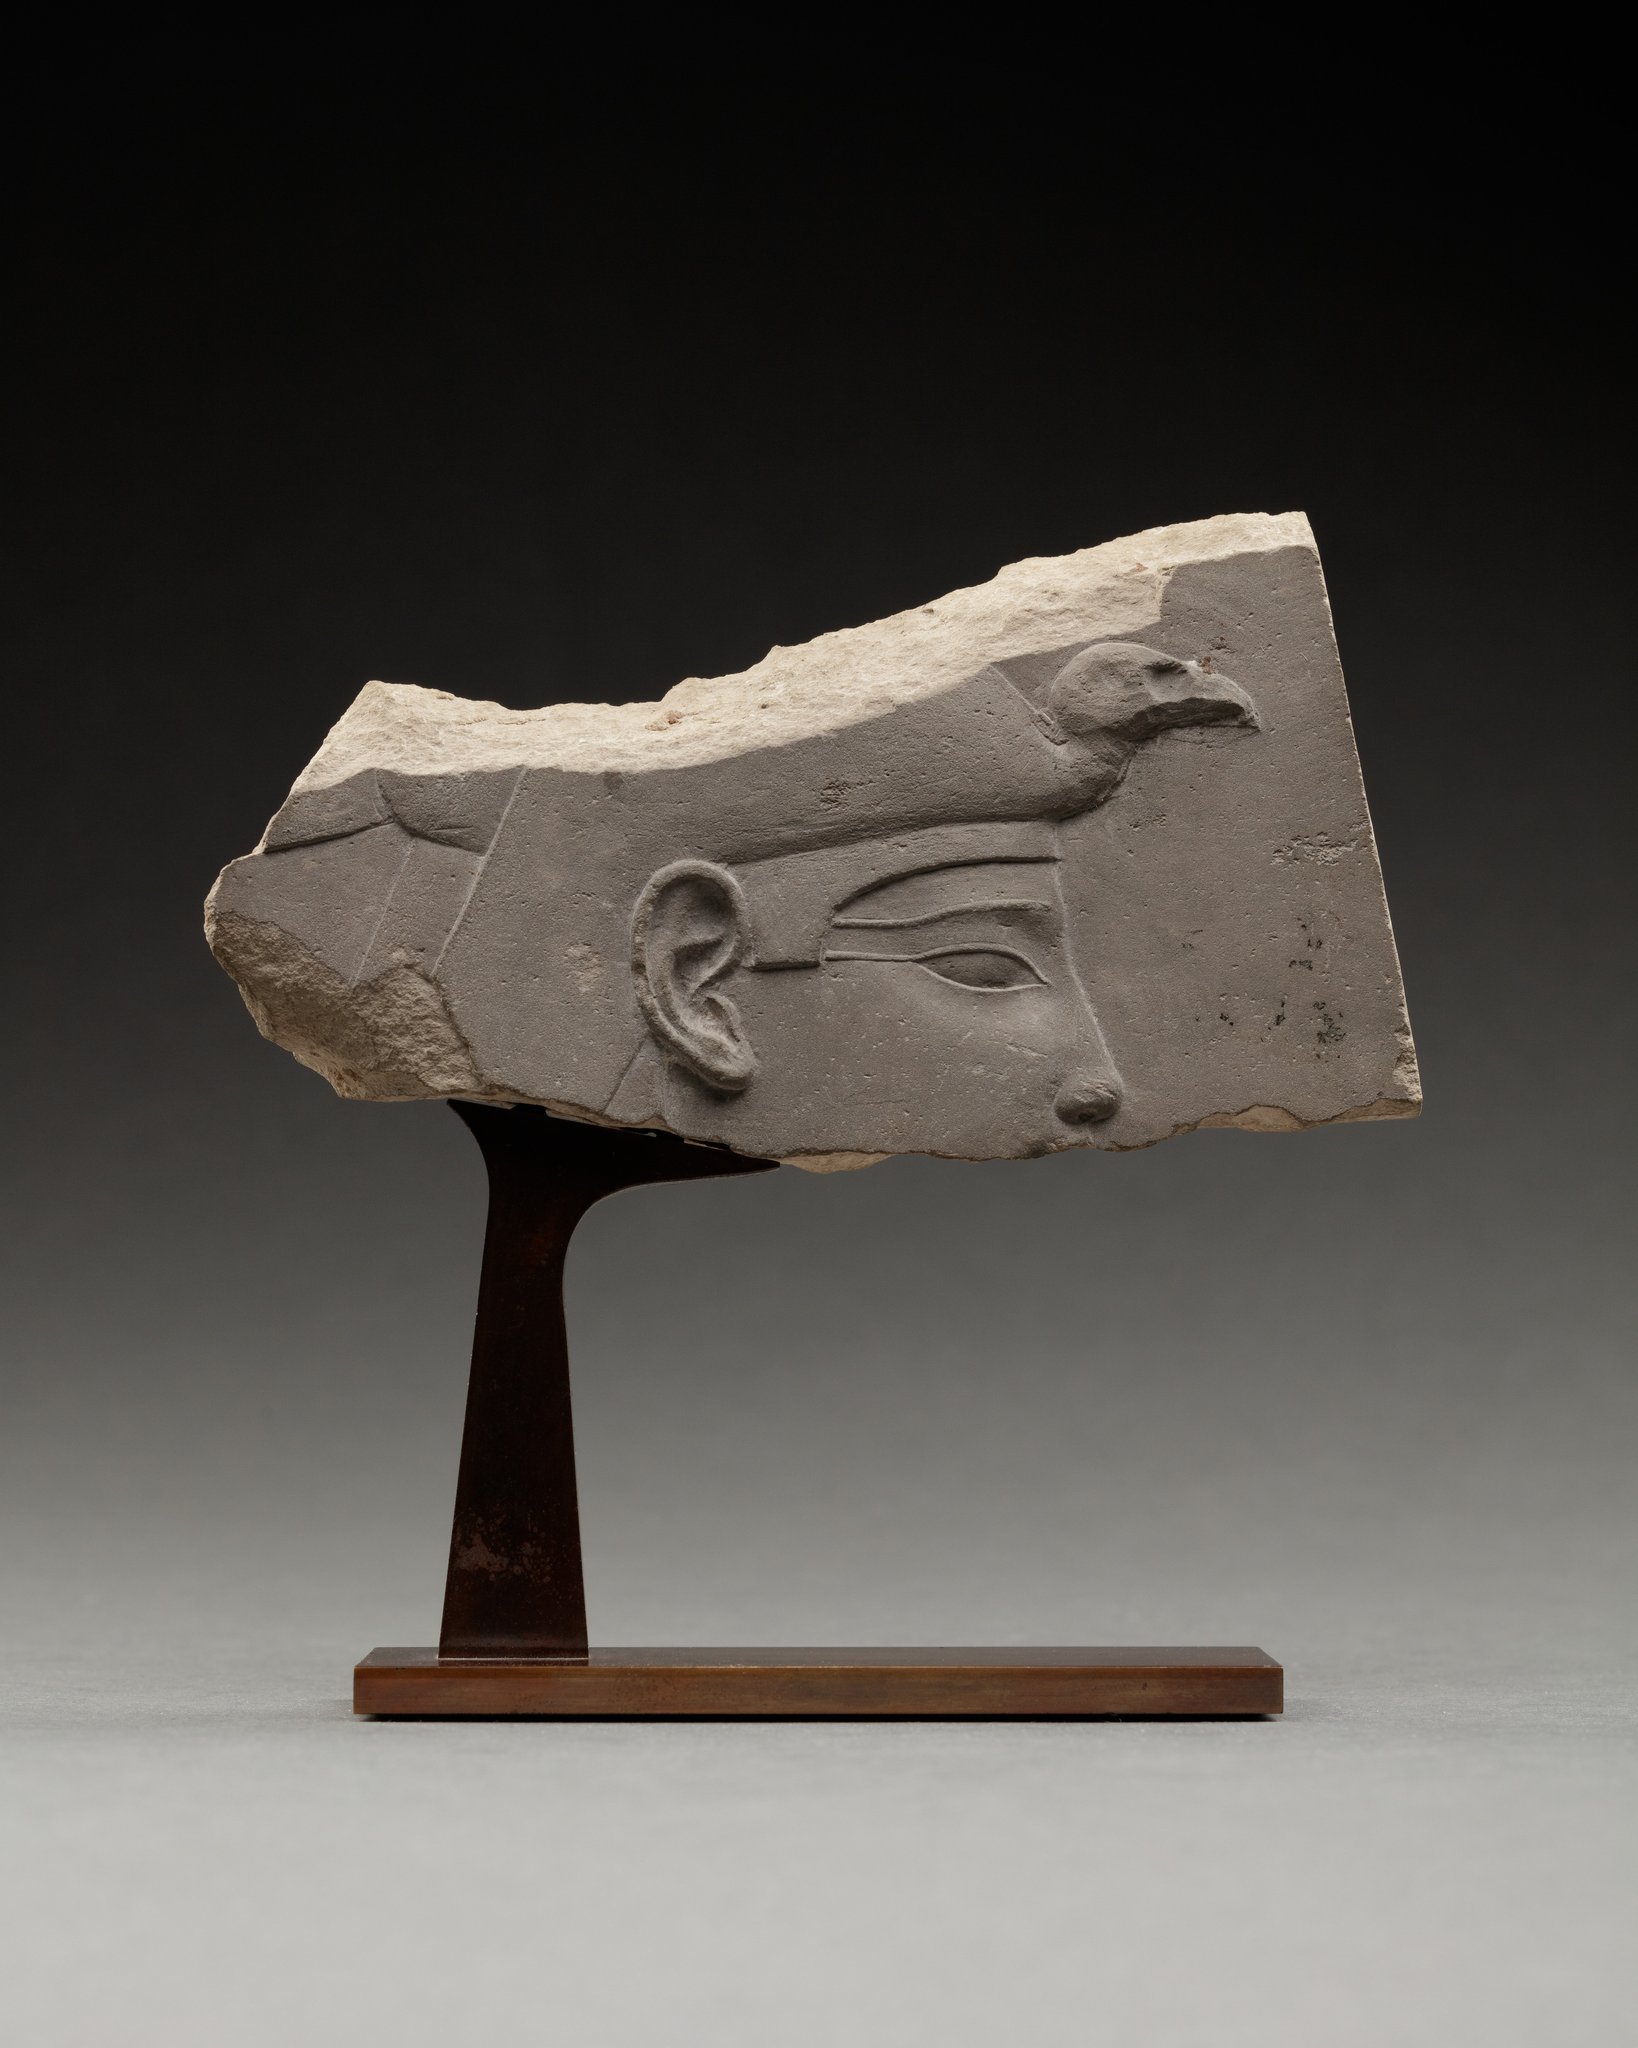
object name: relief, plaque, sculptor's model, donation, royal, head, queen, goddess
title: Relief Plaque with head of a goddess or a queen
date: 400-200 BCE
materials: limestone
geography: egypt